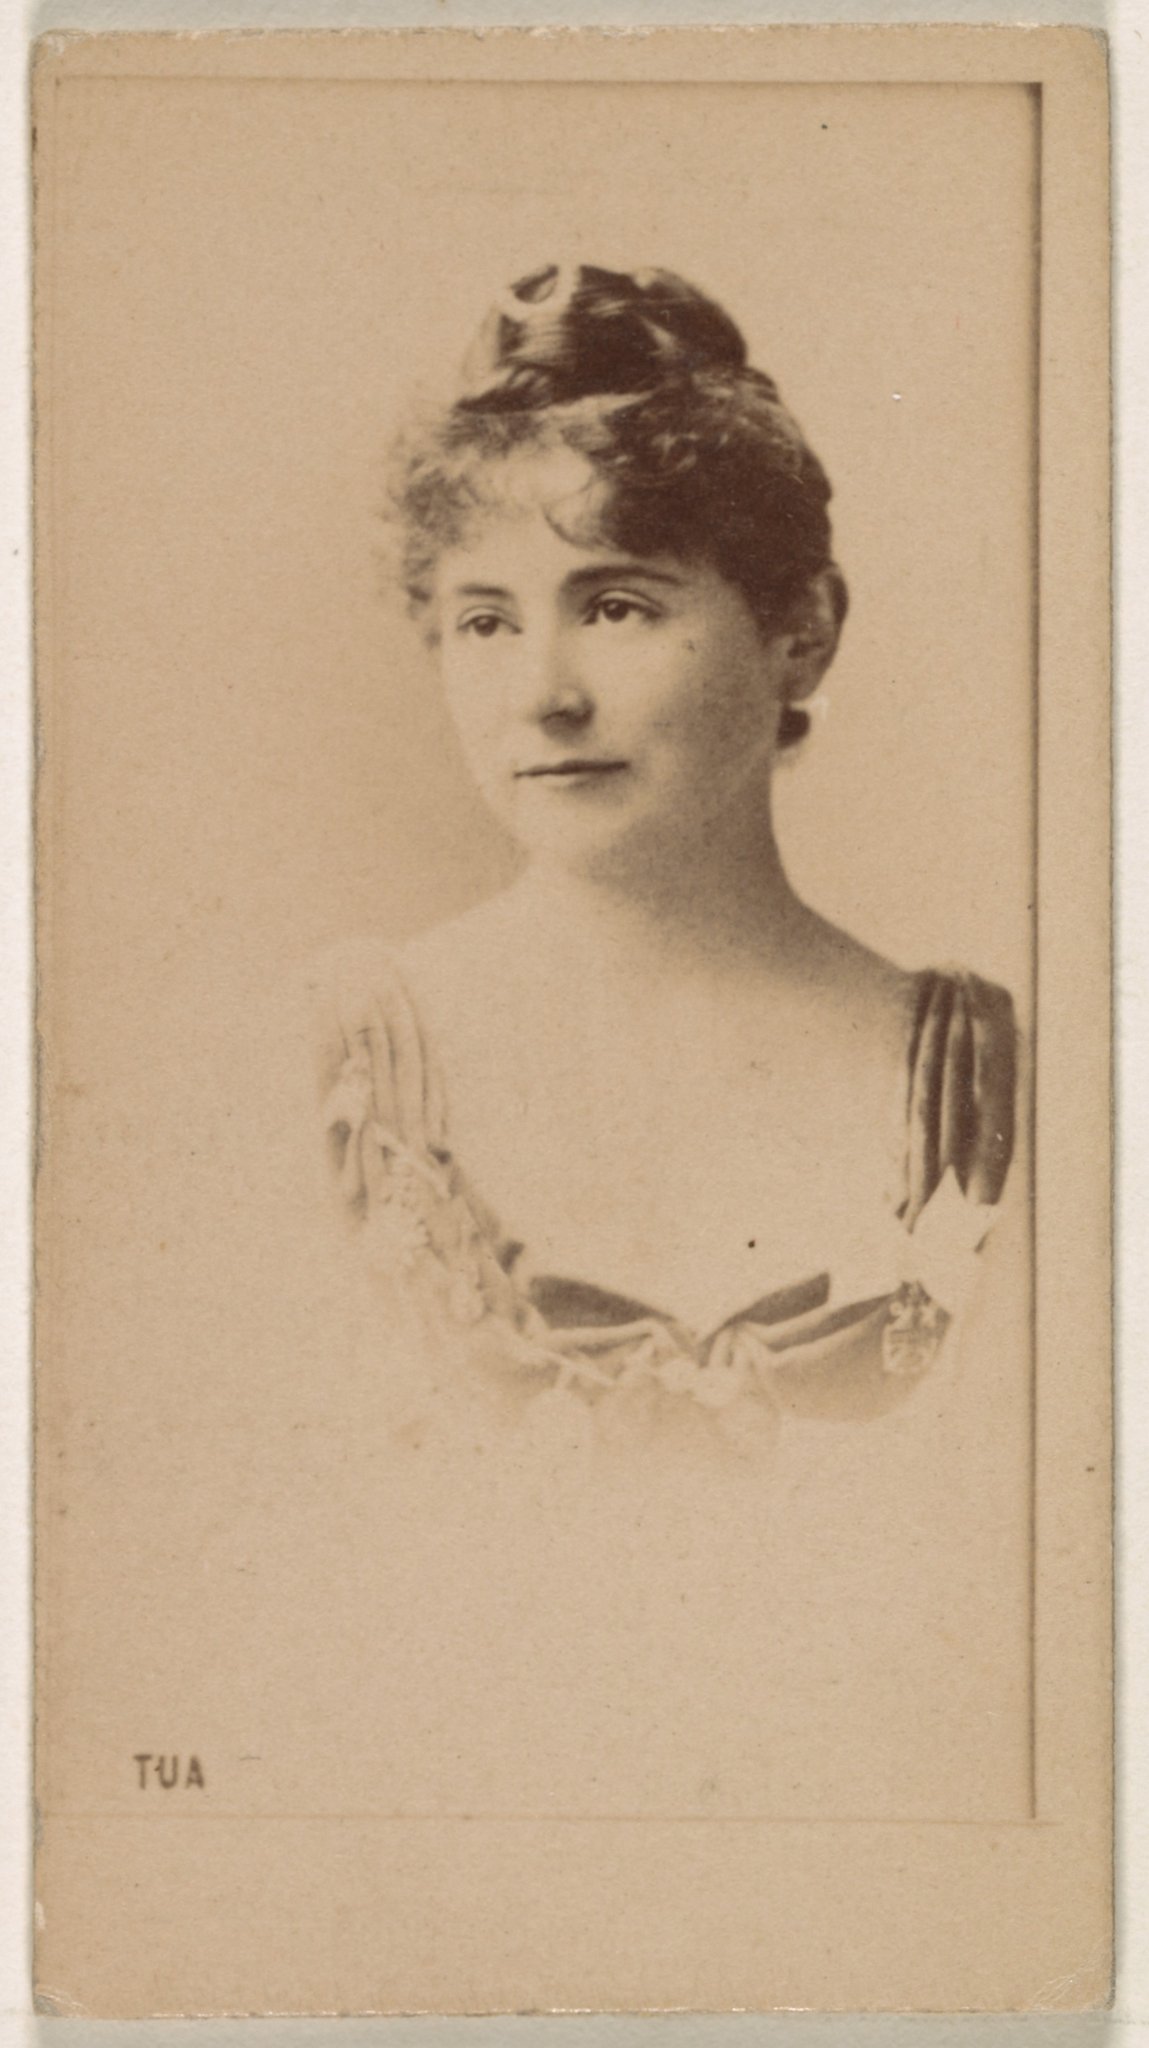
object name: photograph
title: Miss Tua, from the Actresses series (N245) issued by Kinney Brothers to promote Sweet Caporal Cigarettes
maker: kinney brothers tobacco company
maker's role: publisher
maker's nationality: american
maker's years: 1869-2011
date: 1890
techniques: albumen silver print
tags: portraits,women,actresses